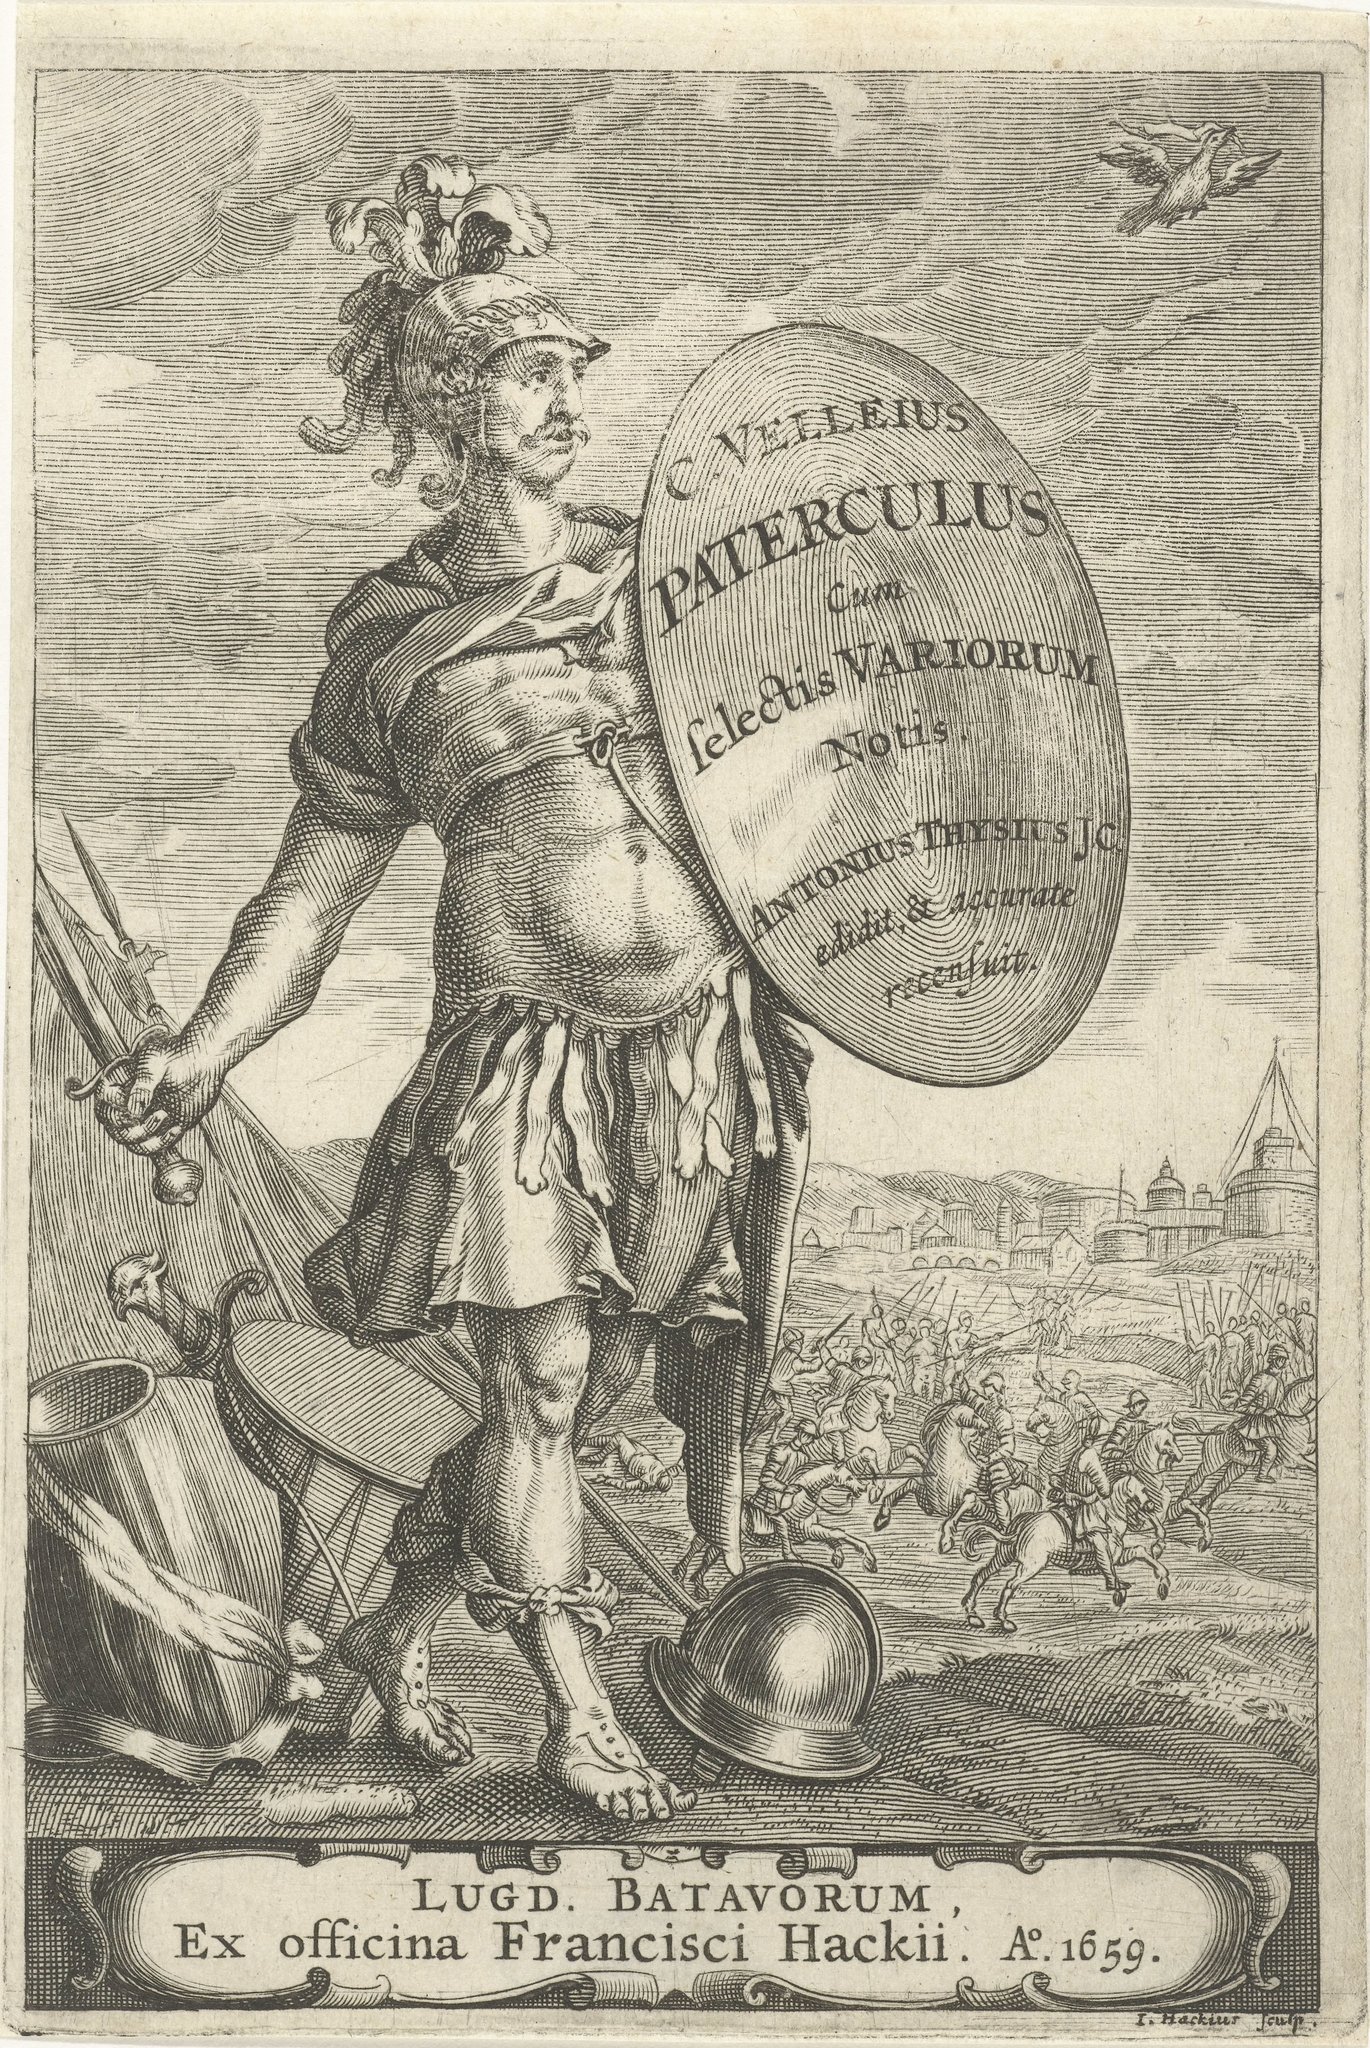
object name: titelblad, titelpagina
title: Titelpagina voor Caius Velleius Paterculus cum Selectis Variorum Notis, 1659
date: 1659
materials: paper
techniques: engraving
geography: leiden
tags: male persons from classical history (+ belonging to roman history)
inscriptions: collector's mark: Lugt 2228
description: Een Romeinse krijgsman en profil naar rechts houdt aan de linkerarm een schild met daarop de tekst van de titel en in zijn rechterhand een zwaard. Op de achtergrond een ruitergevecht, soldaten met lansen en een stad. Op de voorgrond is een stuk van een legertent zichtbaar, een zwaardschede, een trom, een harnas en een helm. In de lucht een vogel, met een ontrold lint in de bek en onderaan in twee regels de plaats en de naam van de uitgever en het jaartal.